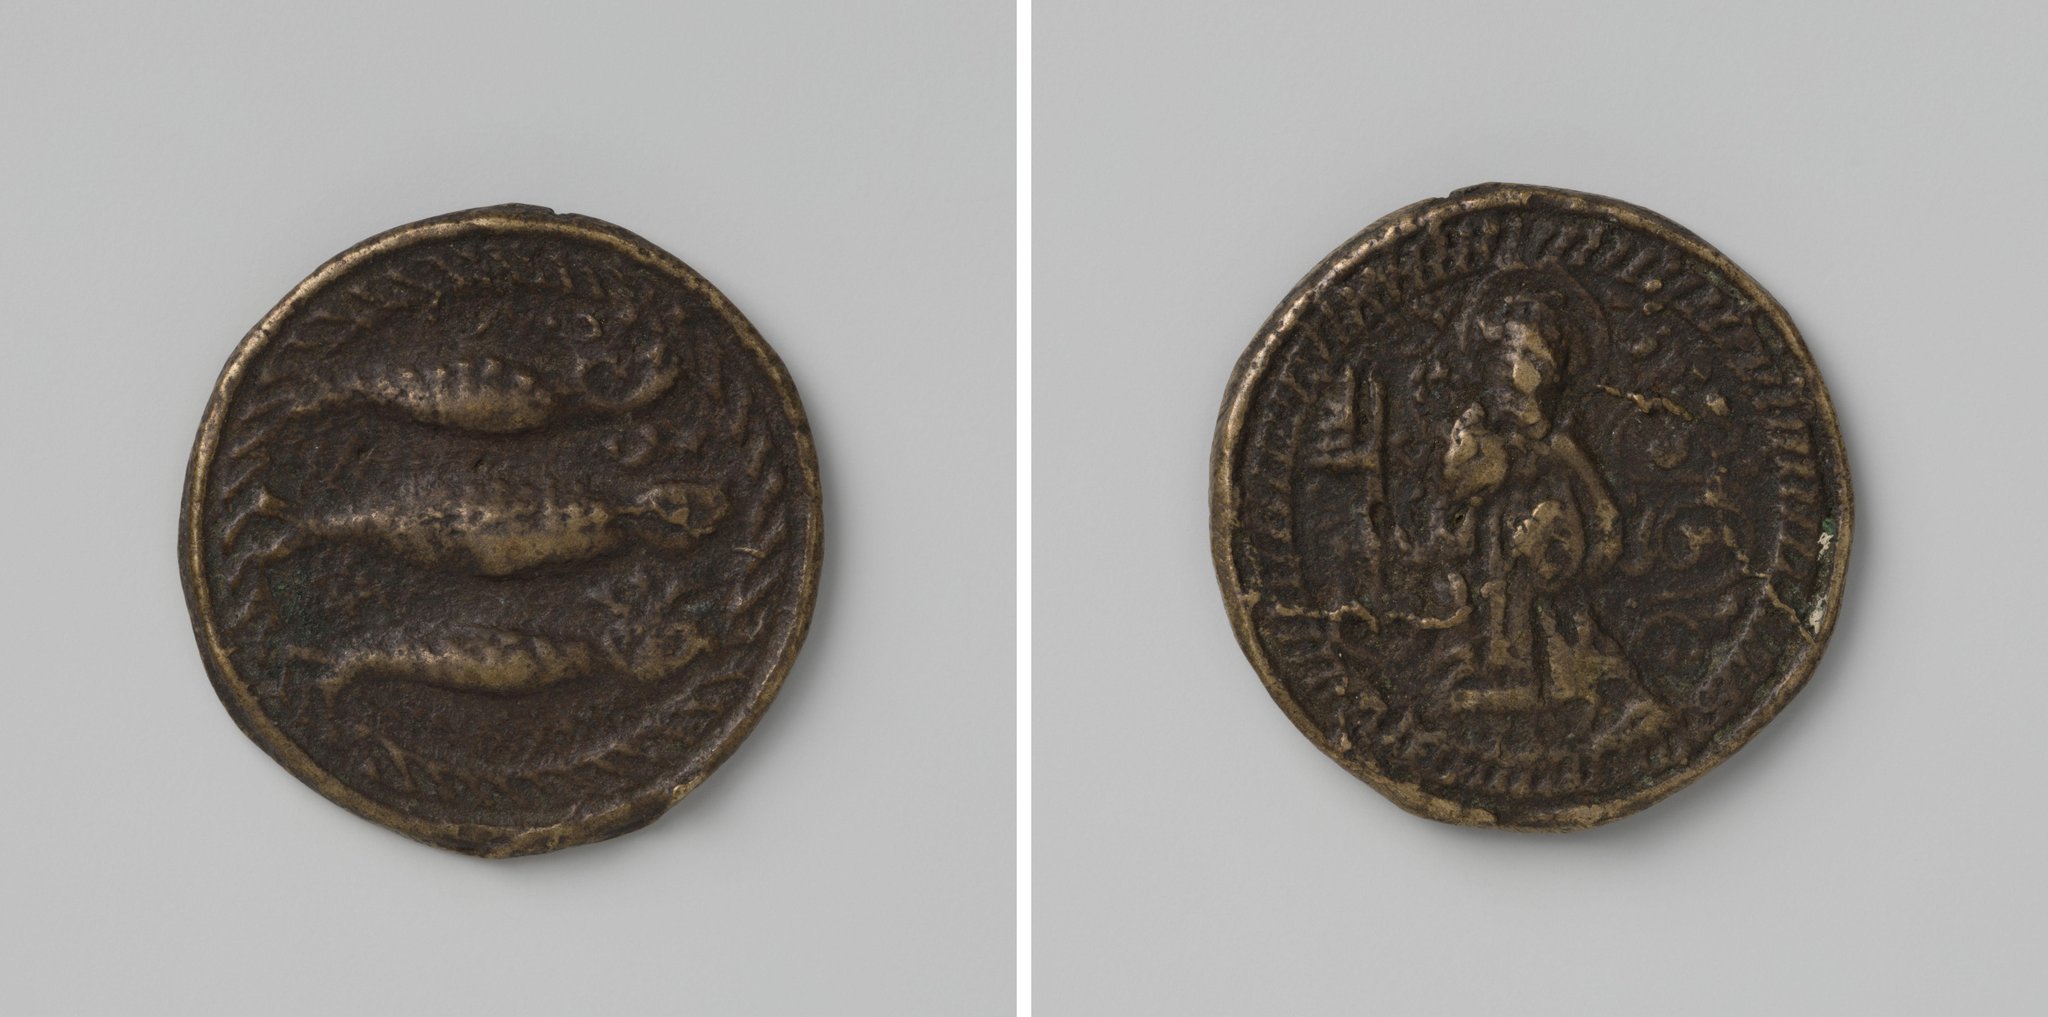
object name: alms token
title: Armenpenning, die bij uitdeling onder de armen recht op haring gaf van Luik of Enkhuizen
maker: Anonymous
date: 1600-1800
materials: copper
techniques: striking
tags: enkhuizen, liège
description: Koperen penning. Voorzijde: drie boven elkaar geplaatste haringen op geruite achtergrond binnen kabelrand. Keerzijde: St. Pieter met sleutel op geruite achtergrond binnen kabelrand.